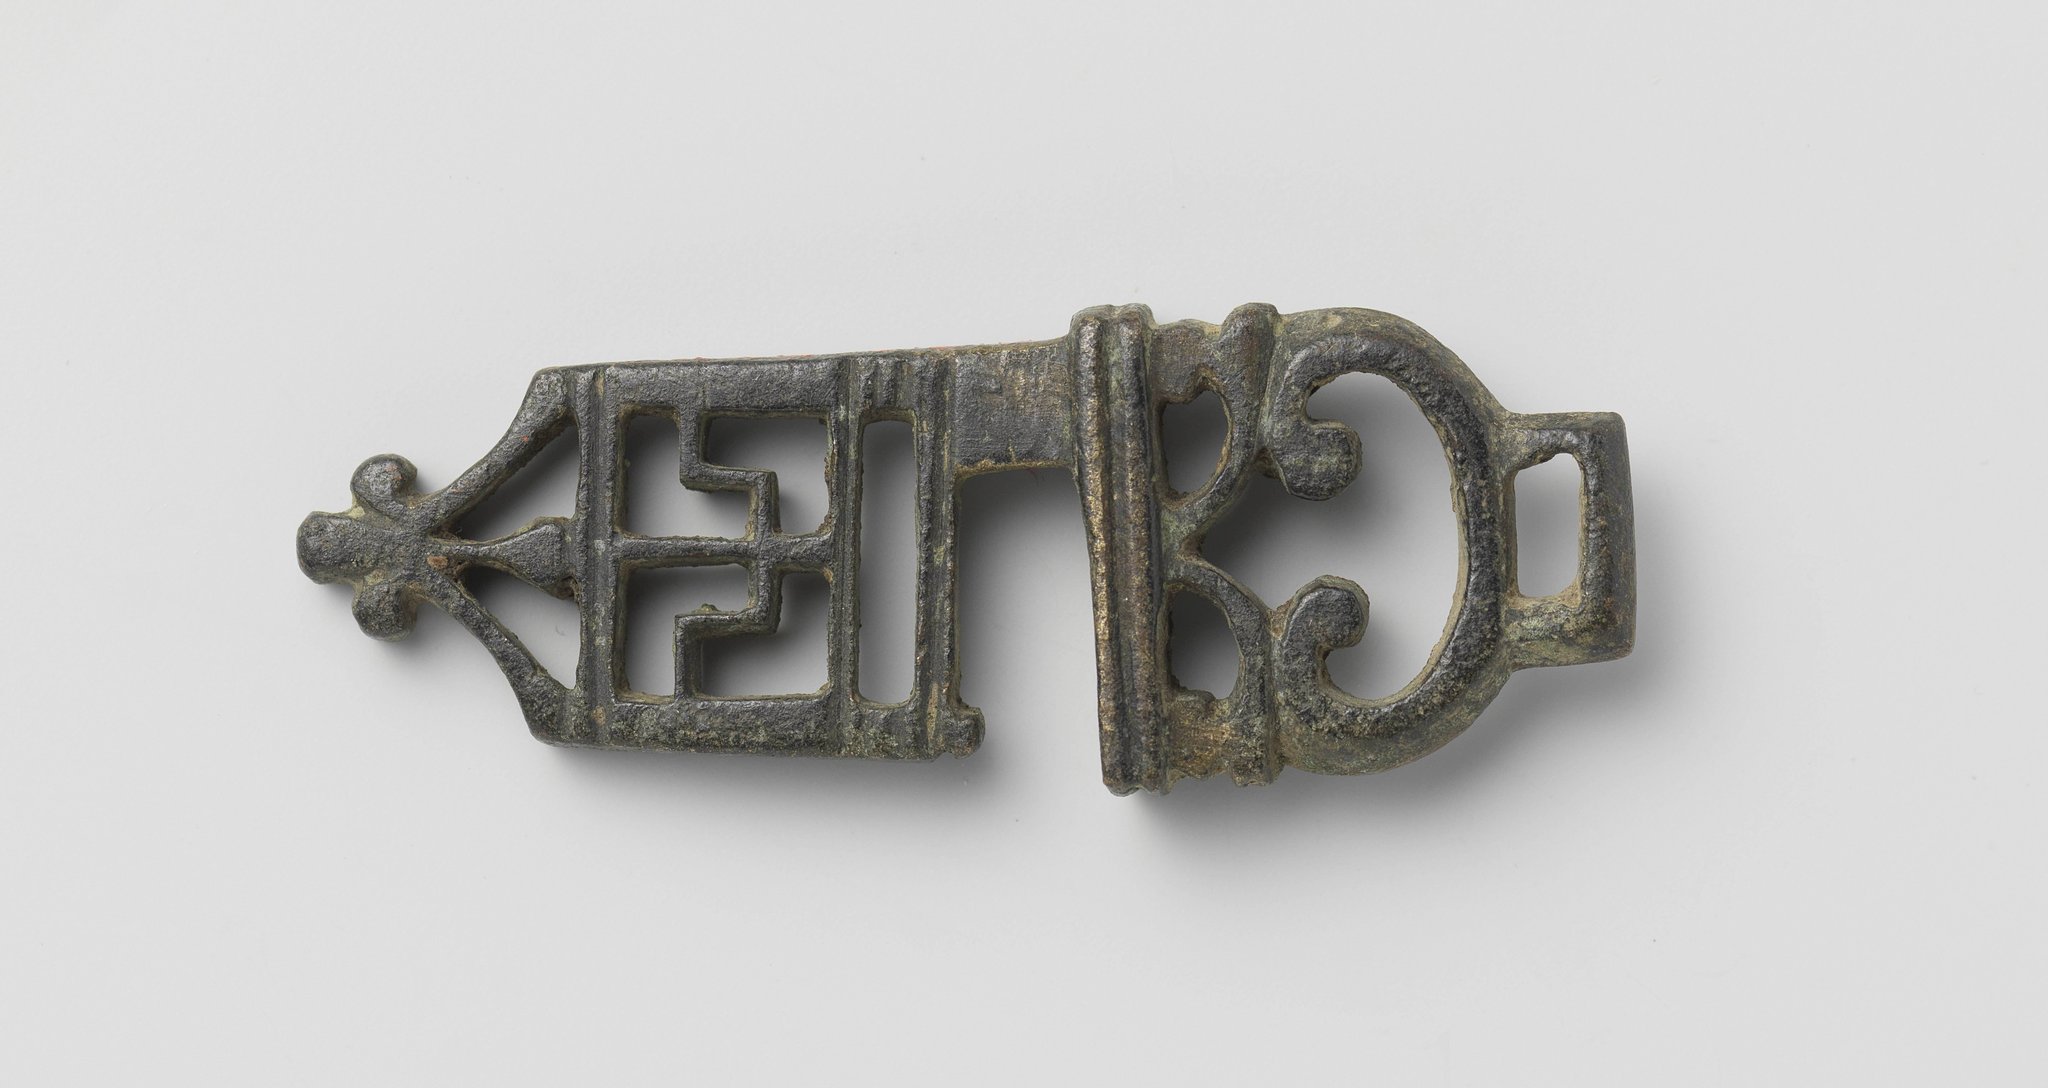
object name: schuifsleutel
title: Key latch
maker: Anonymous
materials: bronze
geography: rome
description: Schuifsleutel waarvan de greep bestaat uit een naar beneden gewende C-voluut, bekroond door vierkant oog. De baard die met een zijverbinding aan de greep bevestigd is, loopt in een blad uit.